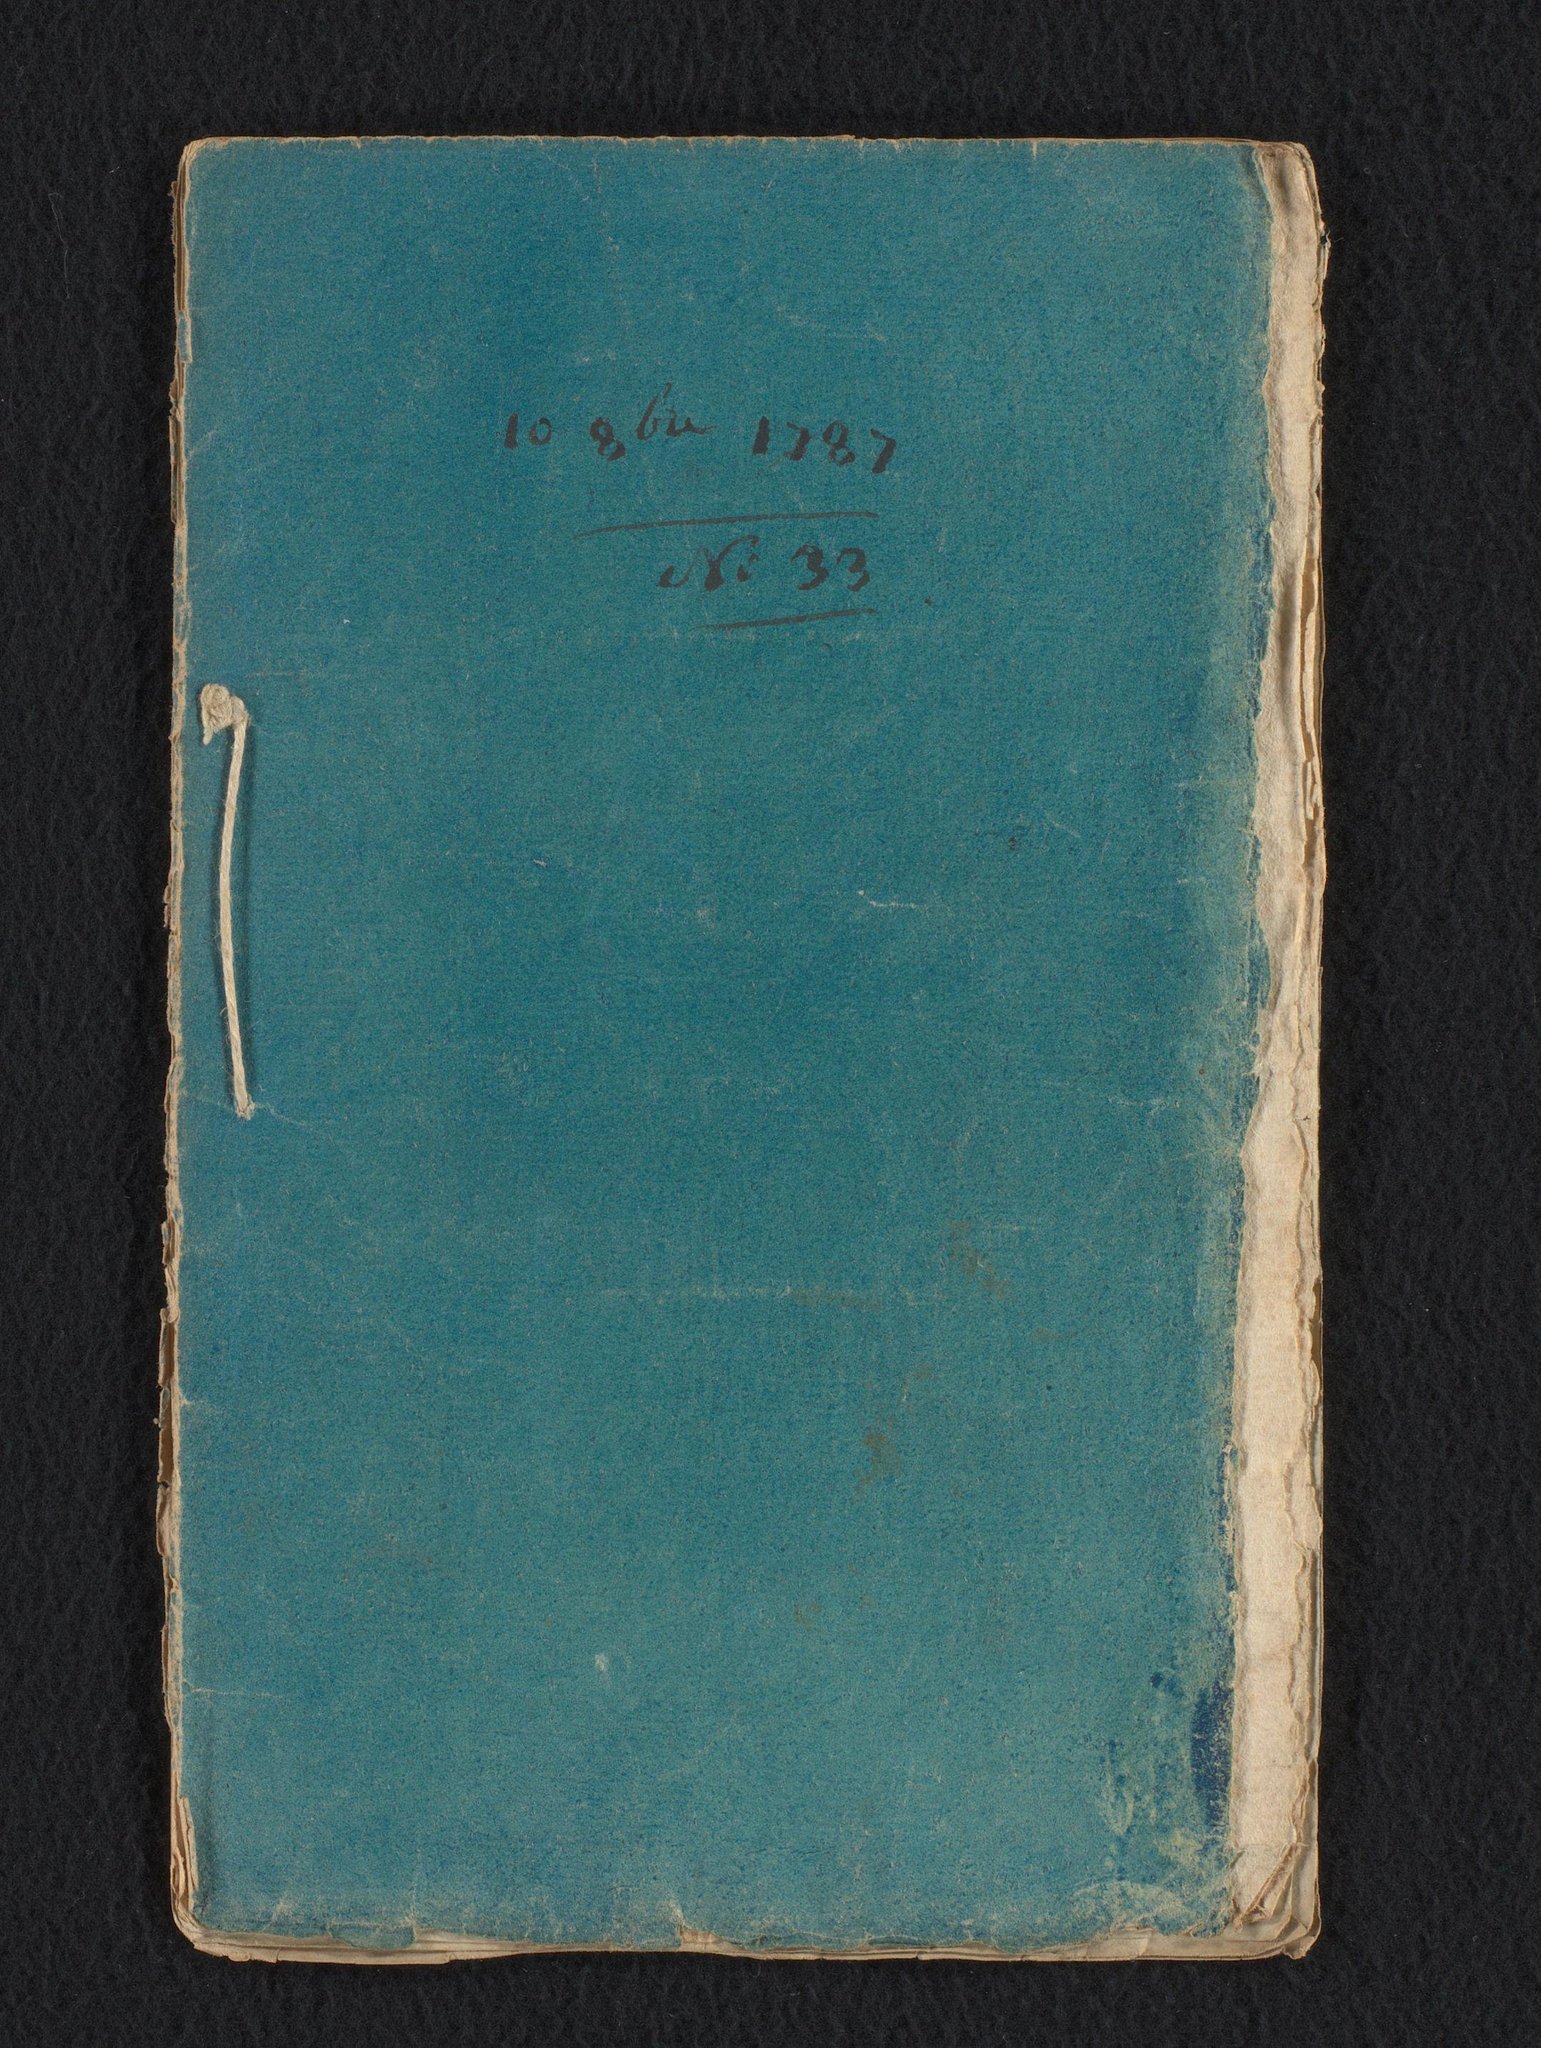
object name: magazine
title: Magasin des Modes Nouvelles Françaises et Anglaises, 10 octobre 1787, 33e cahier, 2e année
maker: buisson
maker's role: publisher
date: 1787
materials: paper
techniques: engraving, hand coloring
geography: paris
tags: fashion plates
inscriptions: date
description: 33e Cahier, 10 octobre 1787, (Seconde Année), pp. 258-262 (1 pag. uitgescheurd) + 3 prenten. Cahier uit het modetijdschrift Magasin des Modes Nouvelles Françaises et Anglaises, Parijs, 20 november 1786 - 21 décembre 1789.